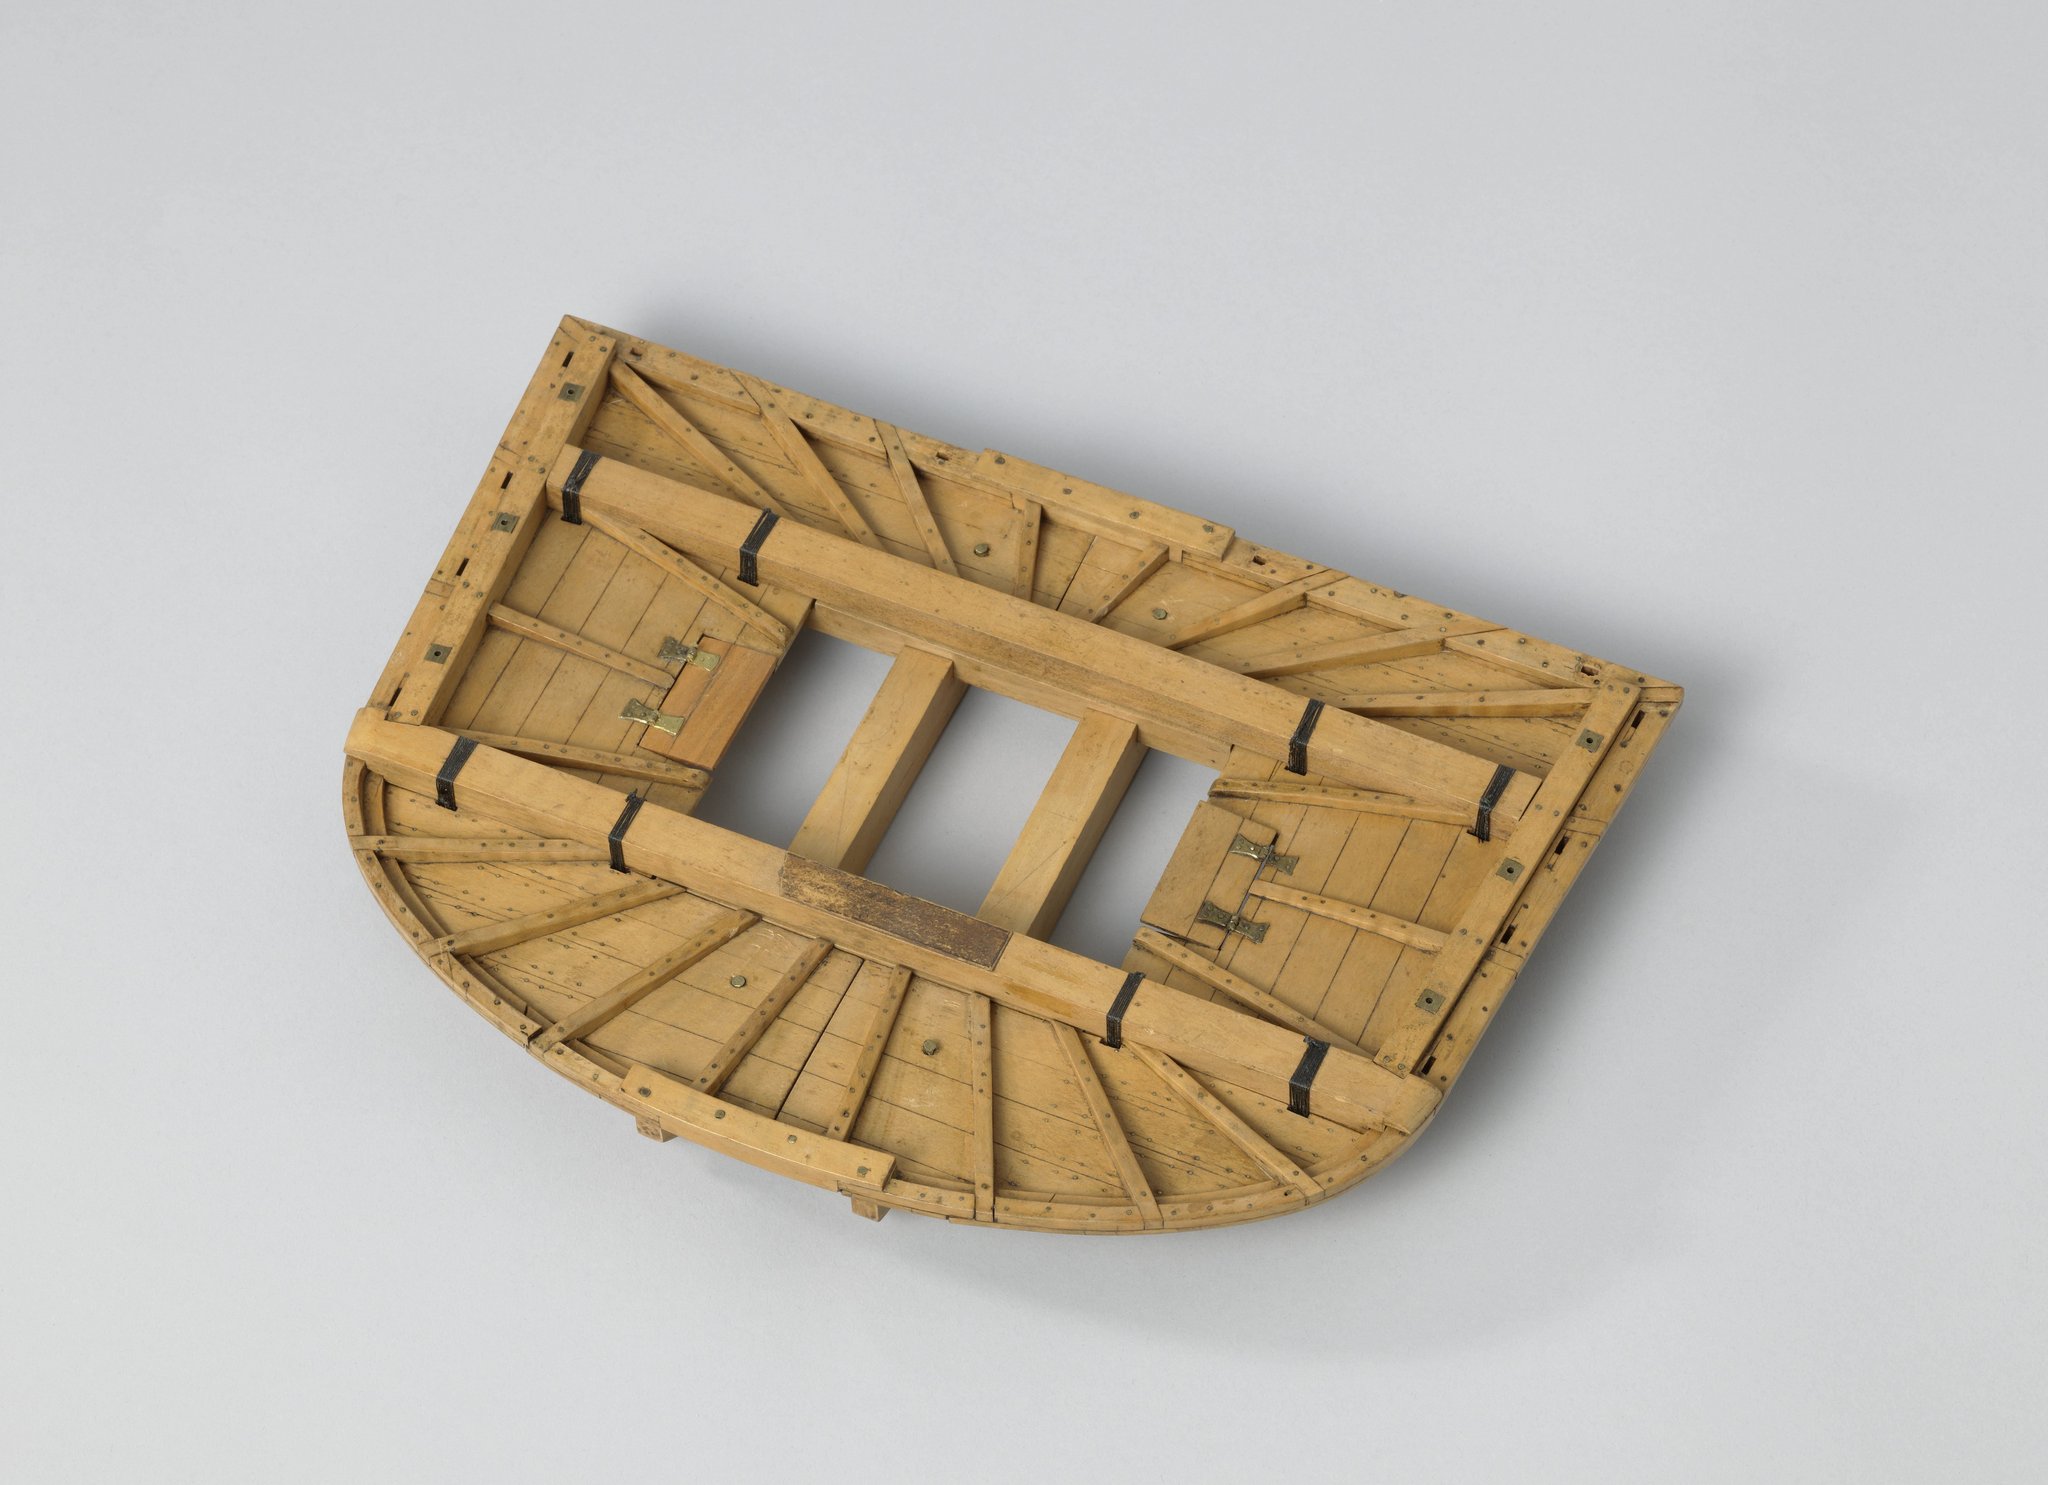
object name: demonstration model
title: Model of a Maintop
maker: Anonymous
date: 1821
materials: brass, wood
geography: united kingdom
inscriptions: inscription, near the lubber’s hole: ‘MARS / uit twee deelen bestaande / C.’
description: Model van een grote mars, aan de voorkant afgerond, met twee langs- en twee dwarszalings onder en knijpers bovenop. De marsvloer is dicht en verstevigd met snaphanen, straalsgewijs rond het soldatengat. Aan weerszijden van het soldatengat zit een klein luikje. Als de knijpers en dwarszalingen verwijderd worden kan de mars in twee helften uiteengenomen worden.